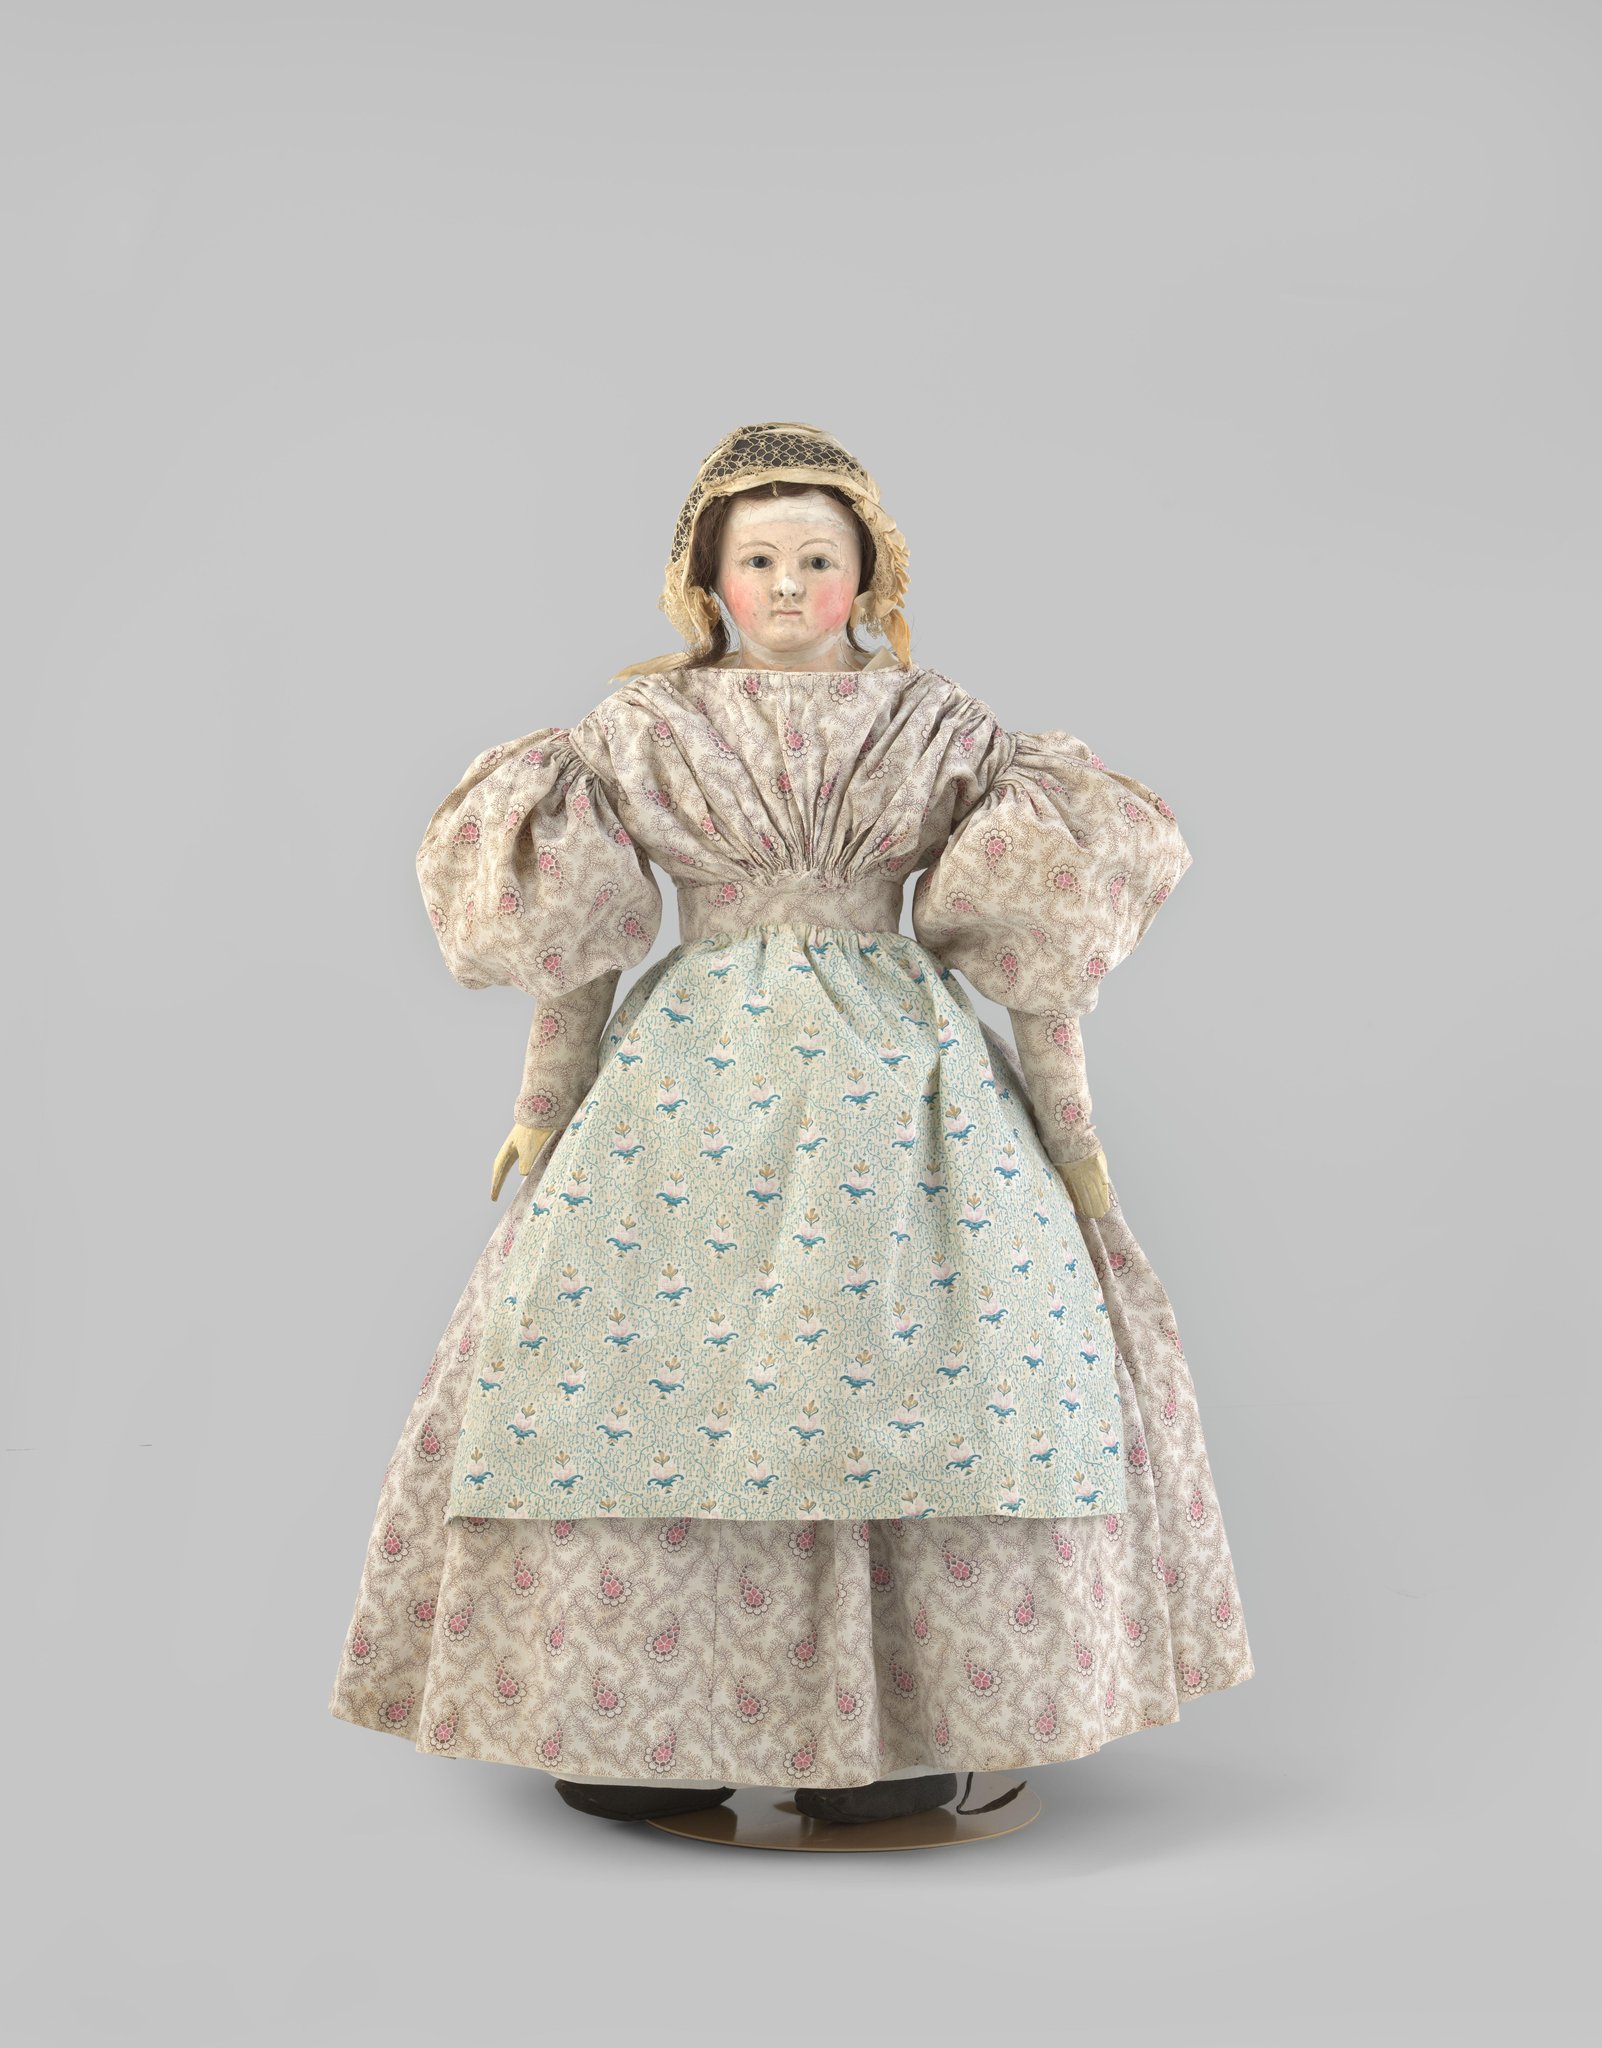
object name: doll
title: Pop gekleed naar de mode van 1830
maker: Anonymous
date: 1830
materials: wood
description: Pop gekleed naar de mode van 1830. Met gebreide kousen, schoenen van zwarte keper, ondergoed van katoen en piqué, jurk van beige katoen met fijne takjes en palm-motieven in rood en bruin, een blauw gebloemd schort en een gebreide muts. Een daarbij behorende witte katoenen jurk met drie neteldoekse stroken. Opmerking: kop beschadigd.